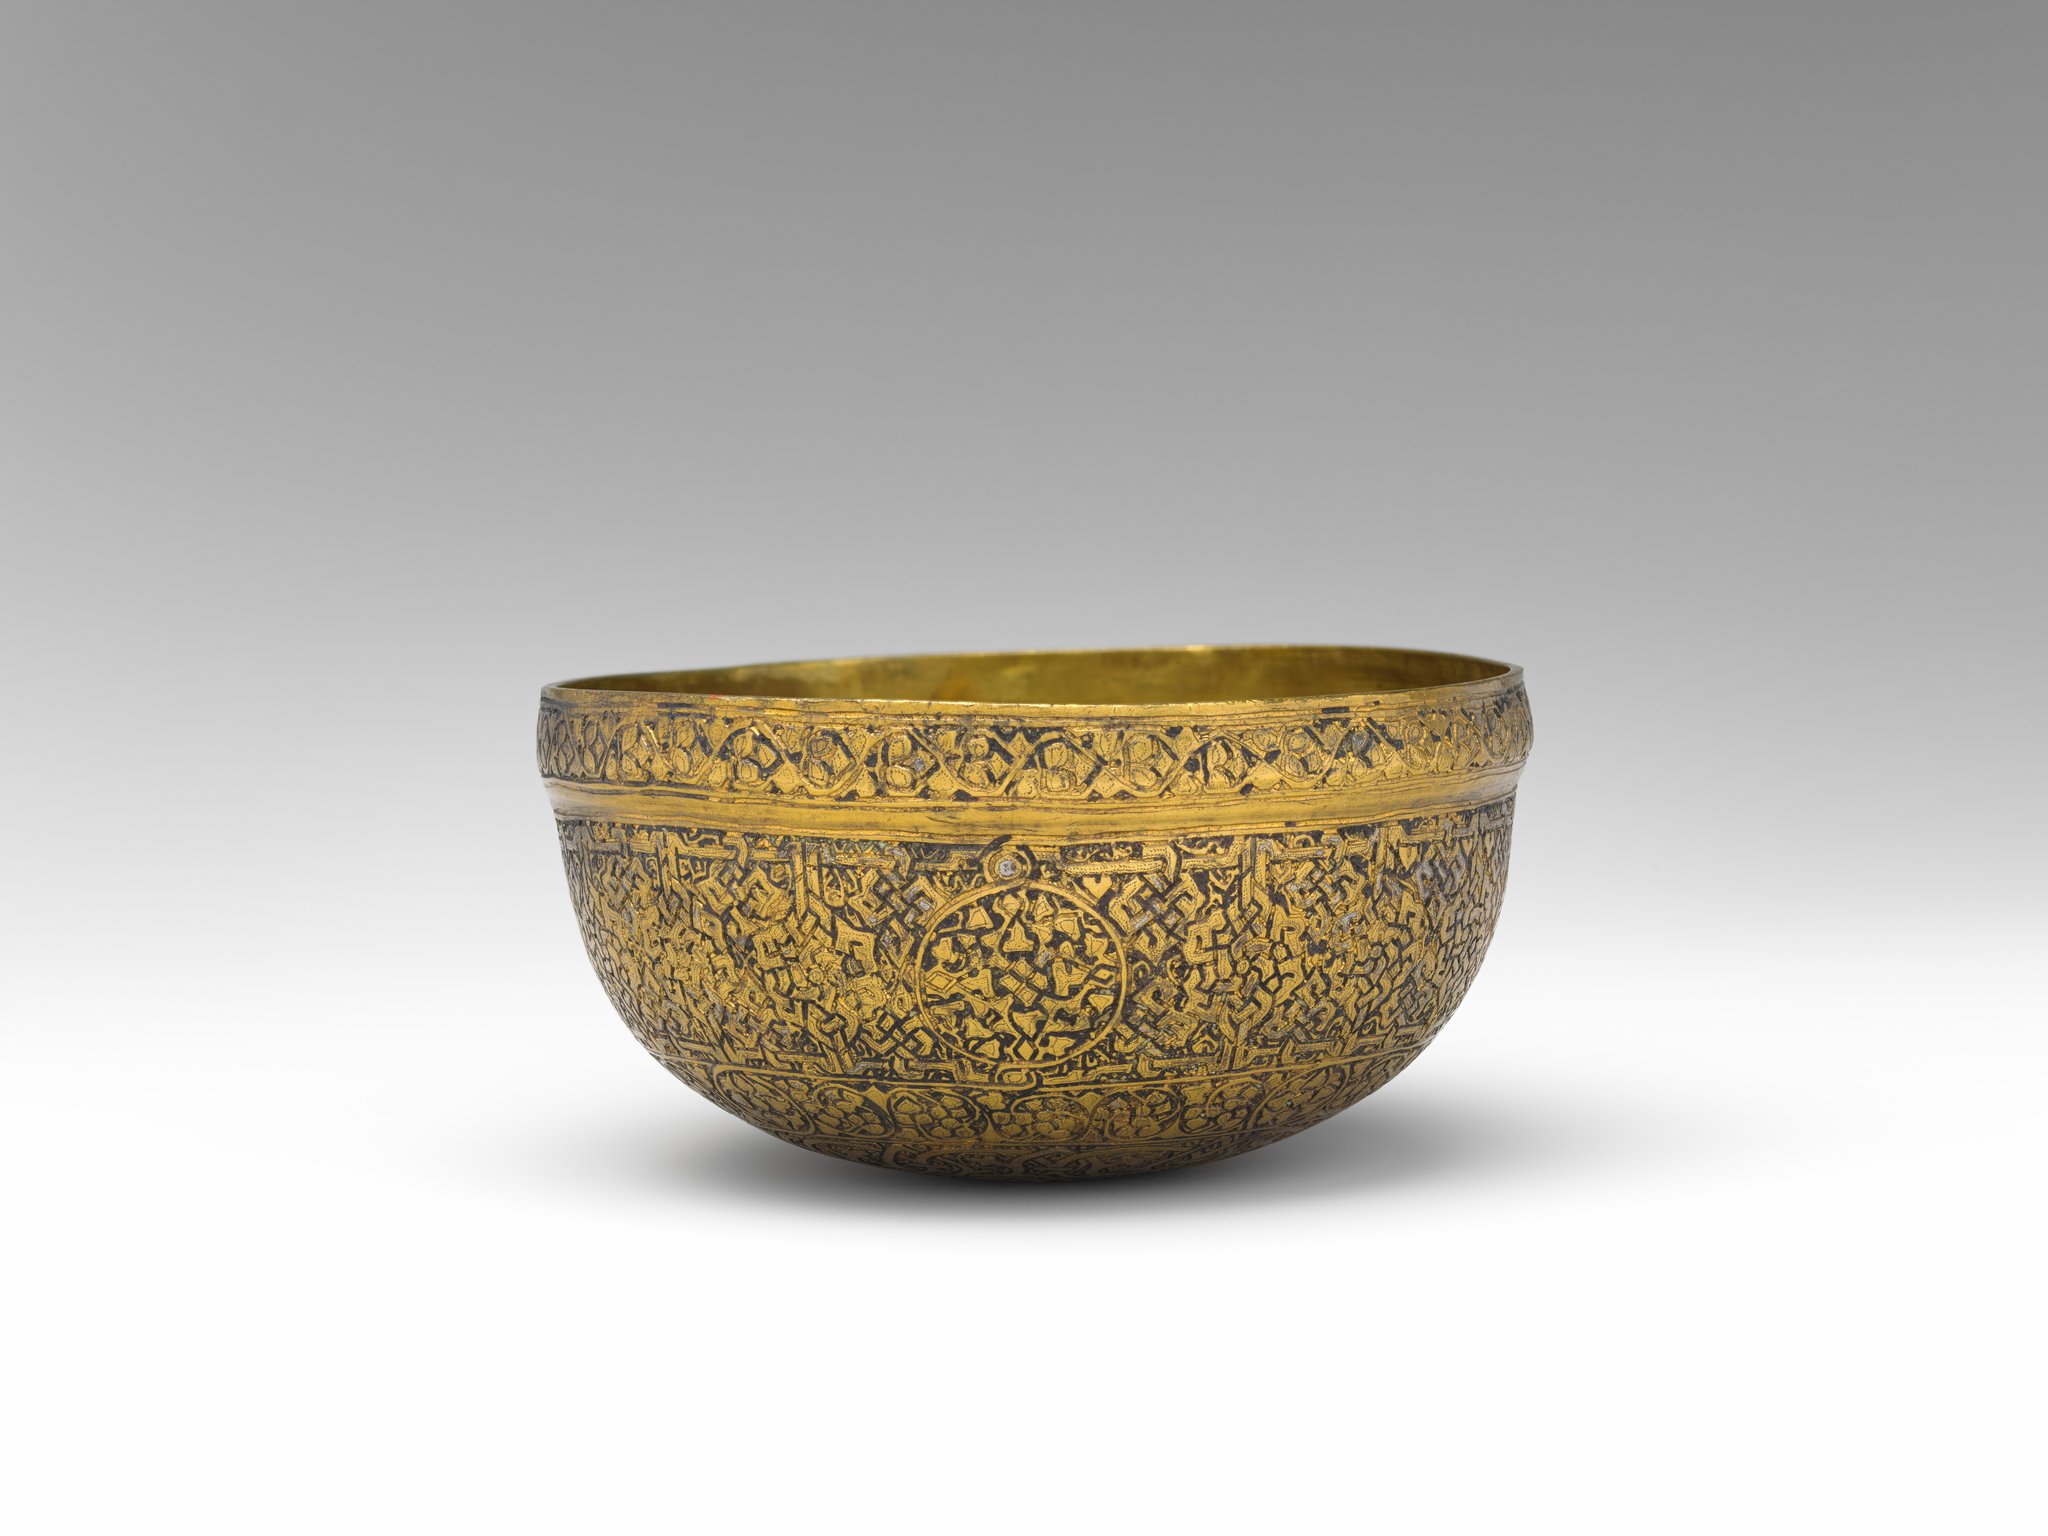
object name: bowl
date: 1401-1500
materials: brass, silver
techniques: inlay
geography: syria